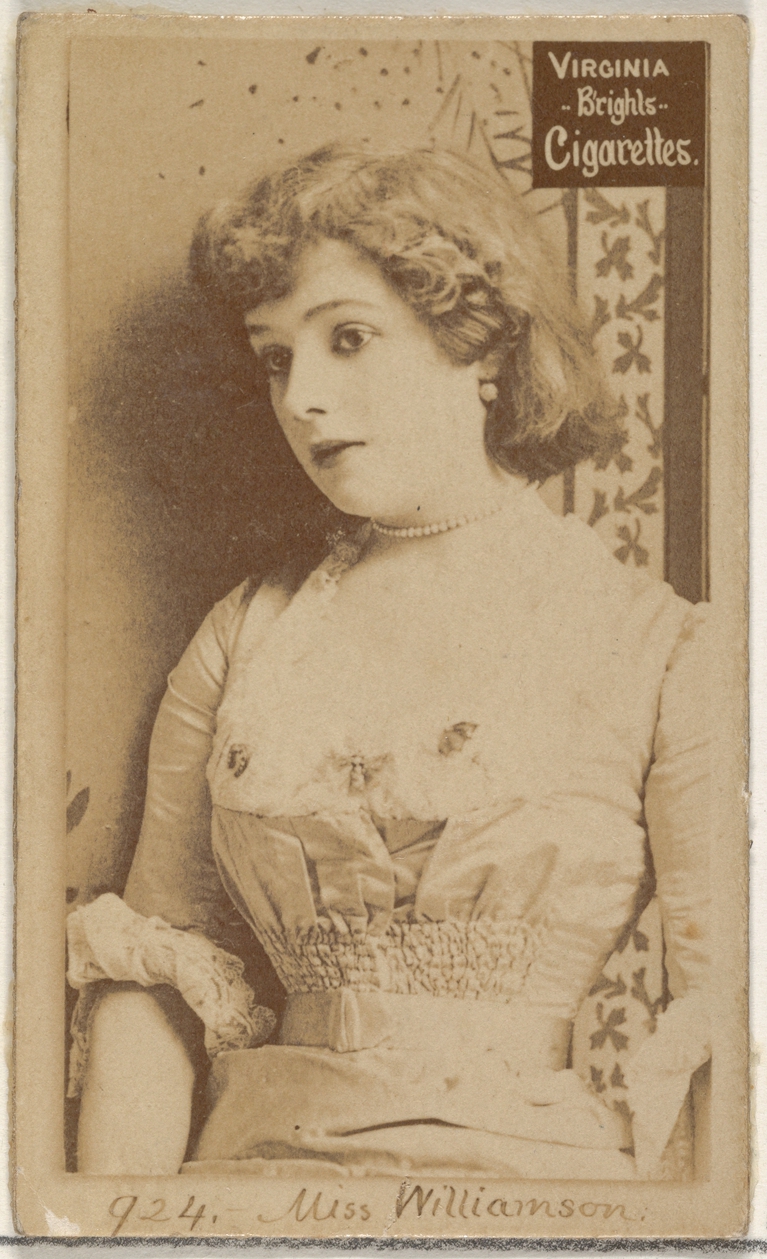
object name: photograph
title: Card 924, Miss Williamson, from the Actors and Actresses series (N45, Type 2) for Virginia Brights Cigarettes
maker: allen & ginter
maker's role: publisher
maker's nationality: american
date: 1888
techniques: albumen silver print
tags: portraits,women,actresses